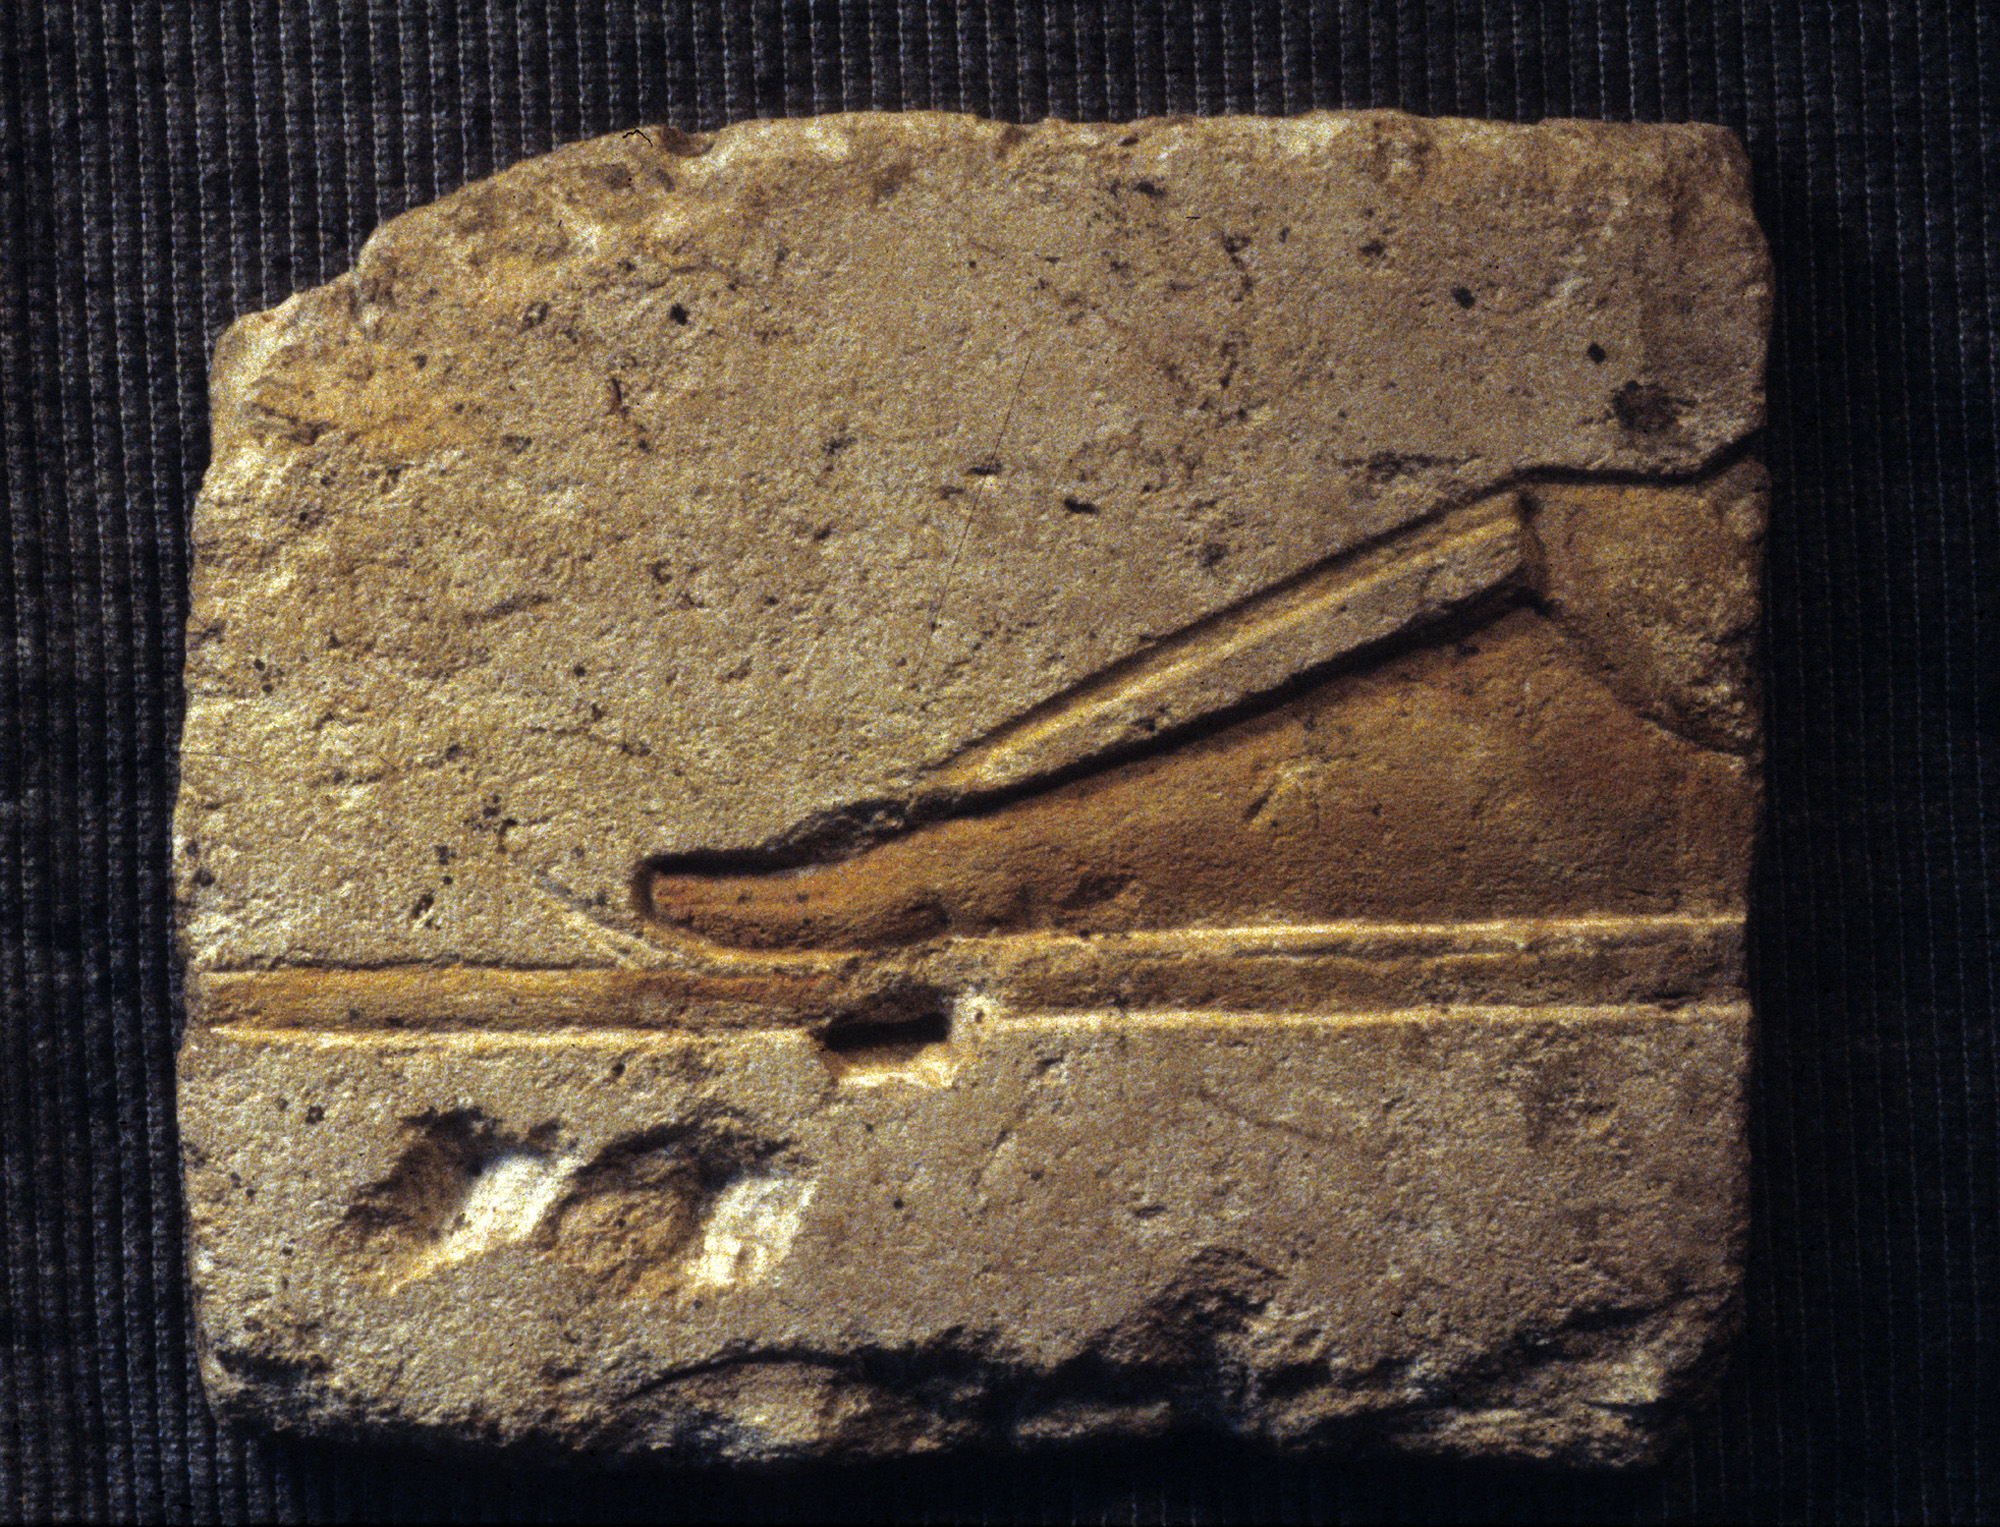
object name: talatat, royal foot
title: Relief with a royal foot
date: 1353-1336 BCE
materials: limestone, paint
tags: feet